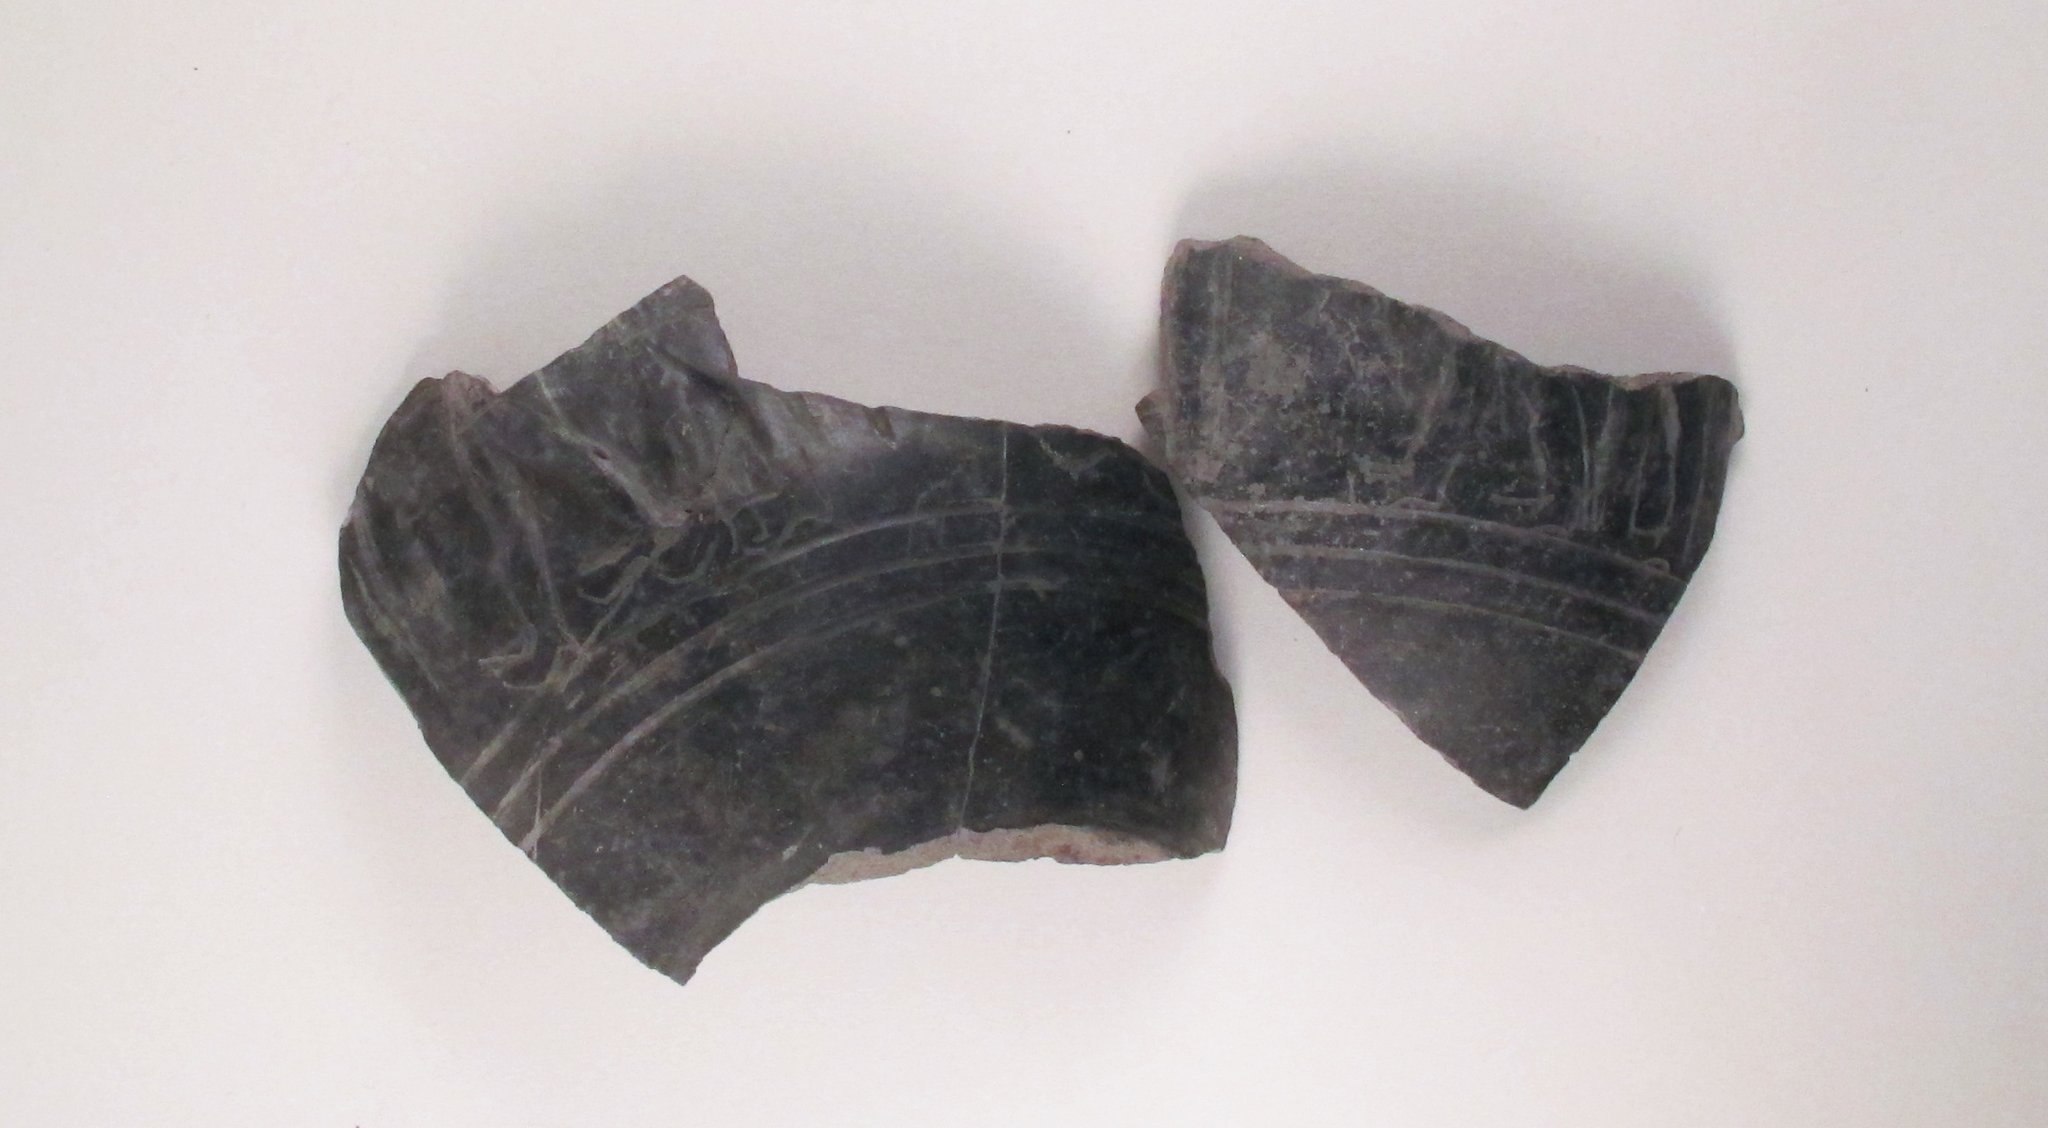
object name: vase fragment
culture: etruscan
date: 575-550 BCE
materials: terracotta